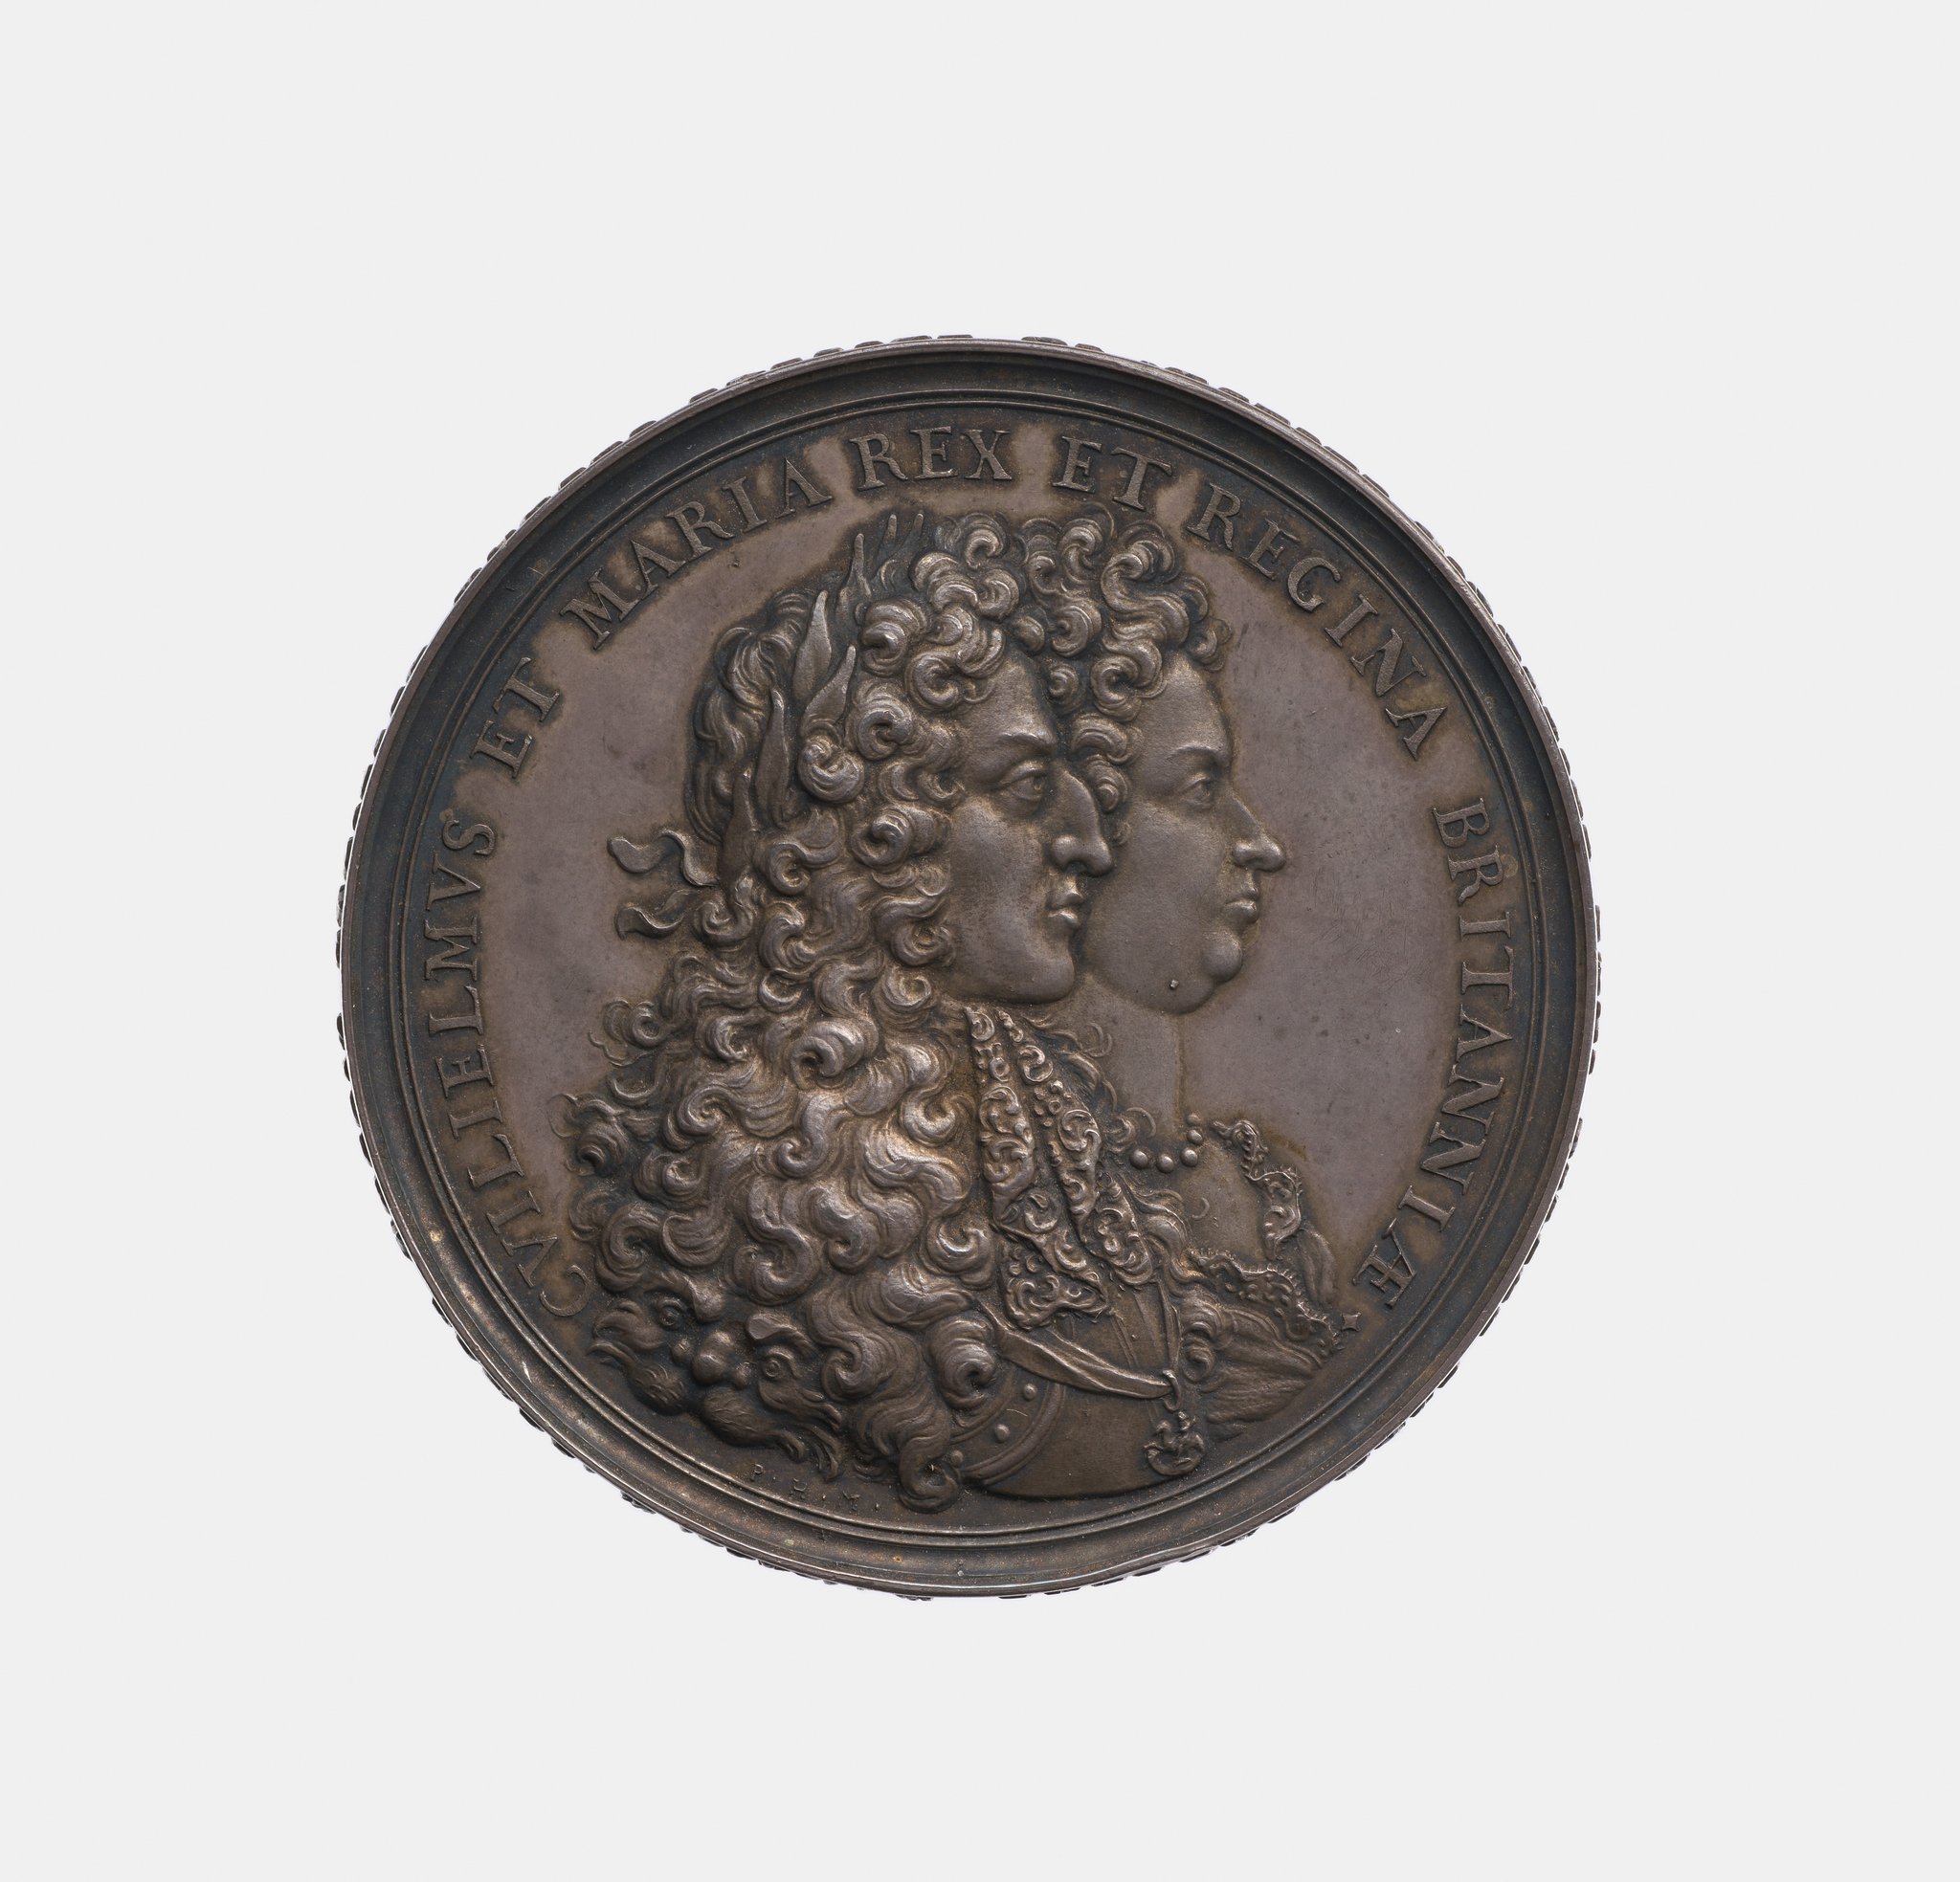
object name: medal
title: William III 1650-1702, and Mary 1662-94, King and Queen of England 1688-94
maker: philipp heinrich mueller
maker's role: artist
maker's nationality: german, augsburg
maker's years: 1654-1719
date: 1689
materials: silver